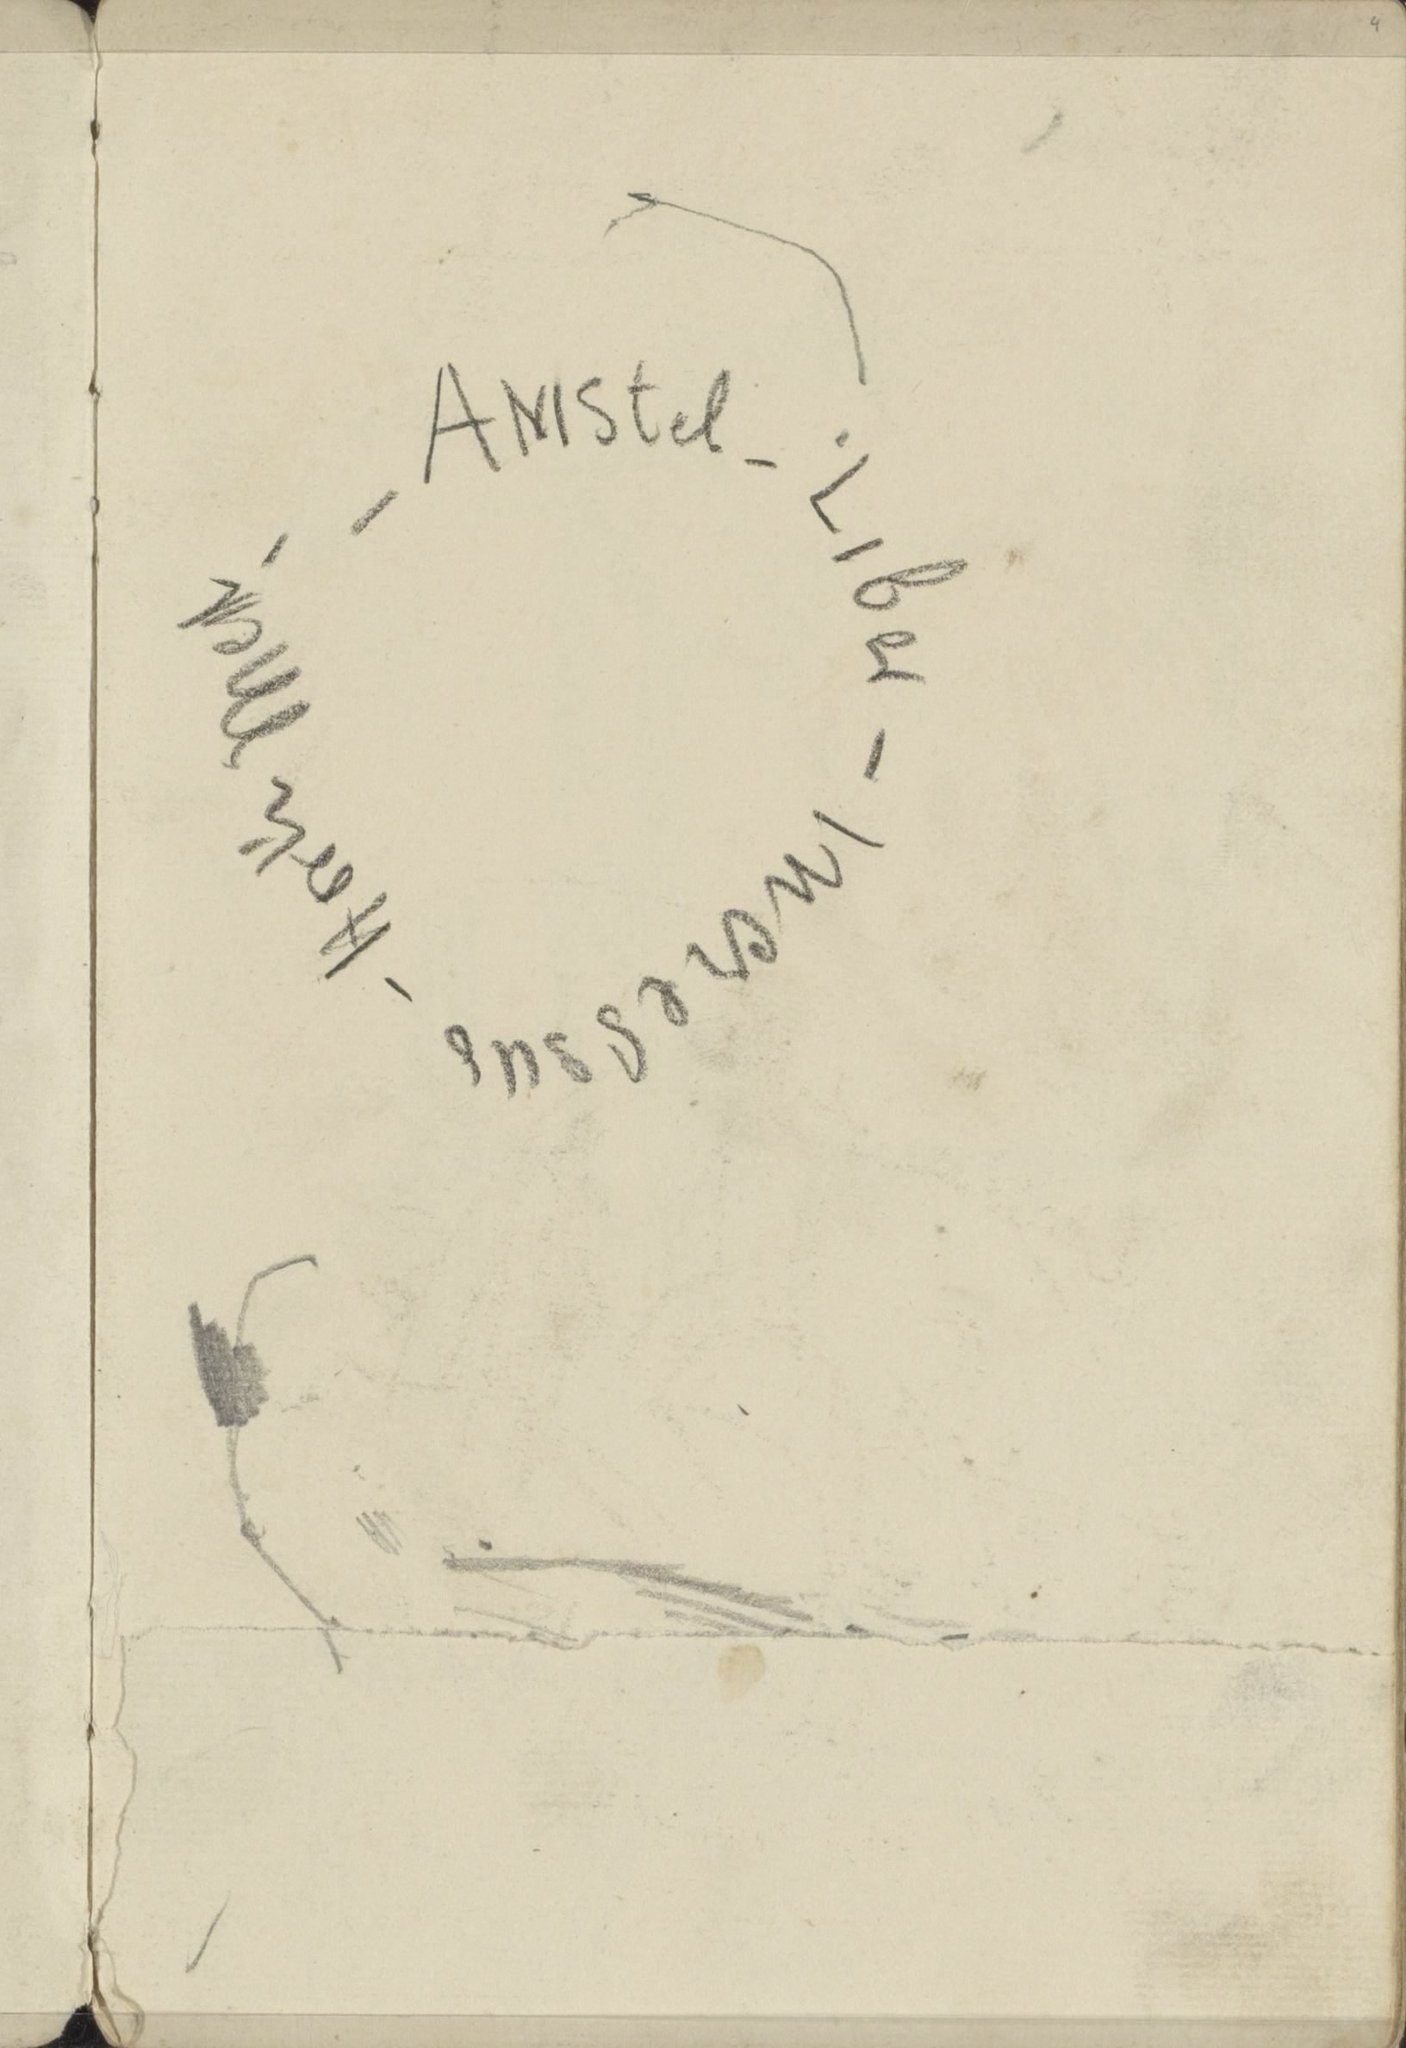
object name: sketchbook leaf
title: Studie van de achterzijde van een toegangspenning voor de Hortus Medicus te Amsterdam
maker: george hendrik breitner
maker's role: draughtsman, painter, print maker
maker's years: 1857-1923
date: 1884-1886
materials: chalk, paper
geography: the hague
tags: medal, badge of a guild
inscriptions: edge inscription: ‘Amstel Liber Ingressus Horti Med’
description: Randschrift 'Amstel Liber Ingressus Horti Med'. Pagina 4 uit een schetsboek met 19 bladen.